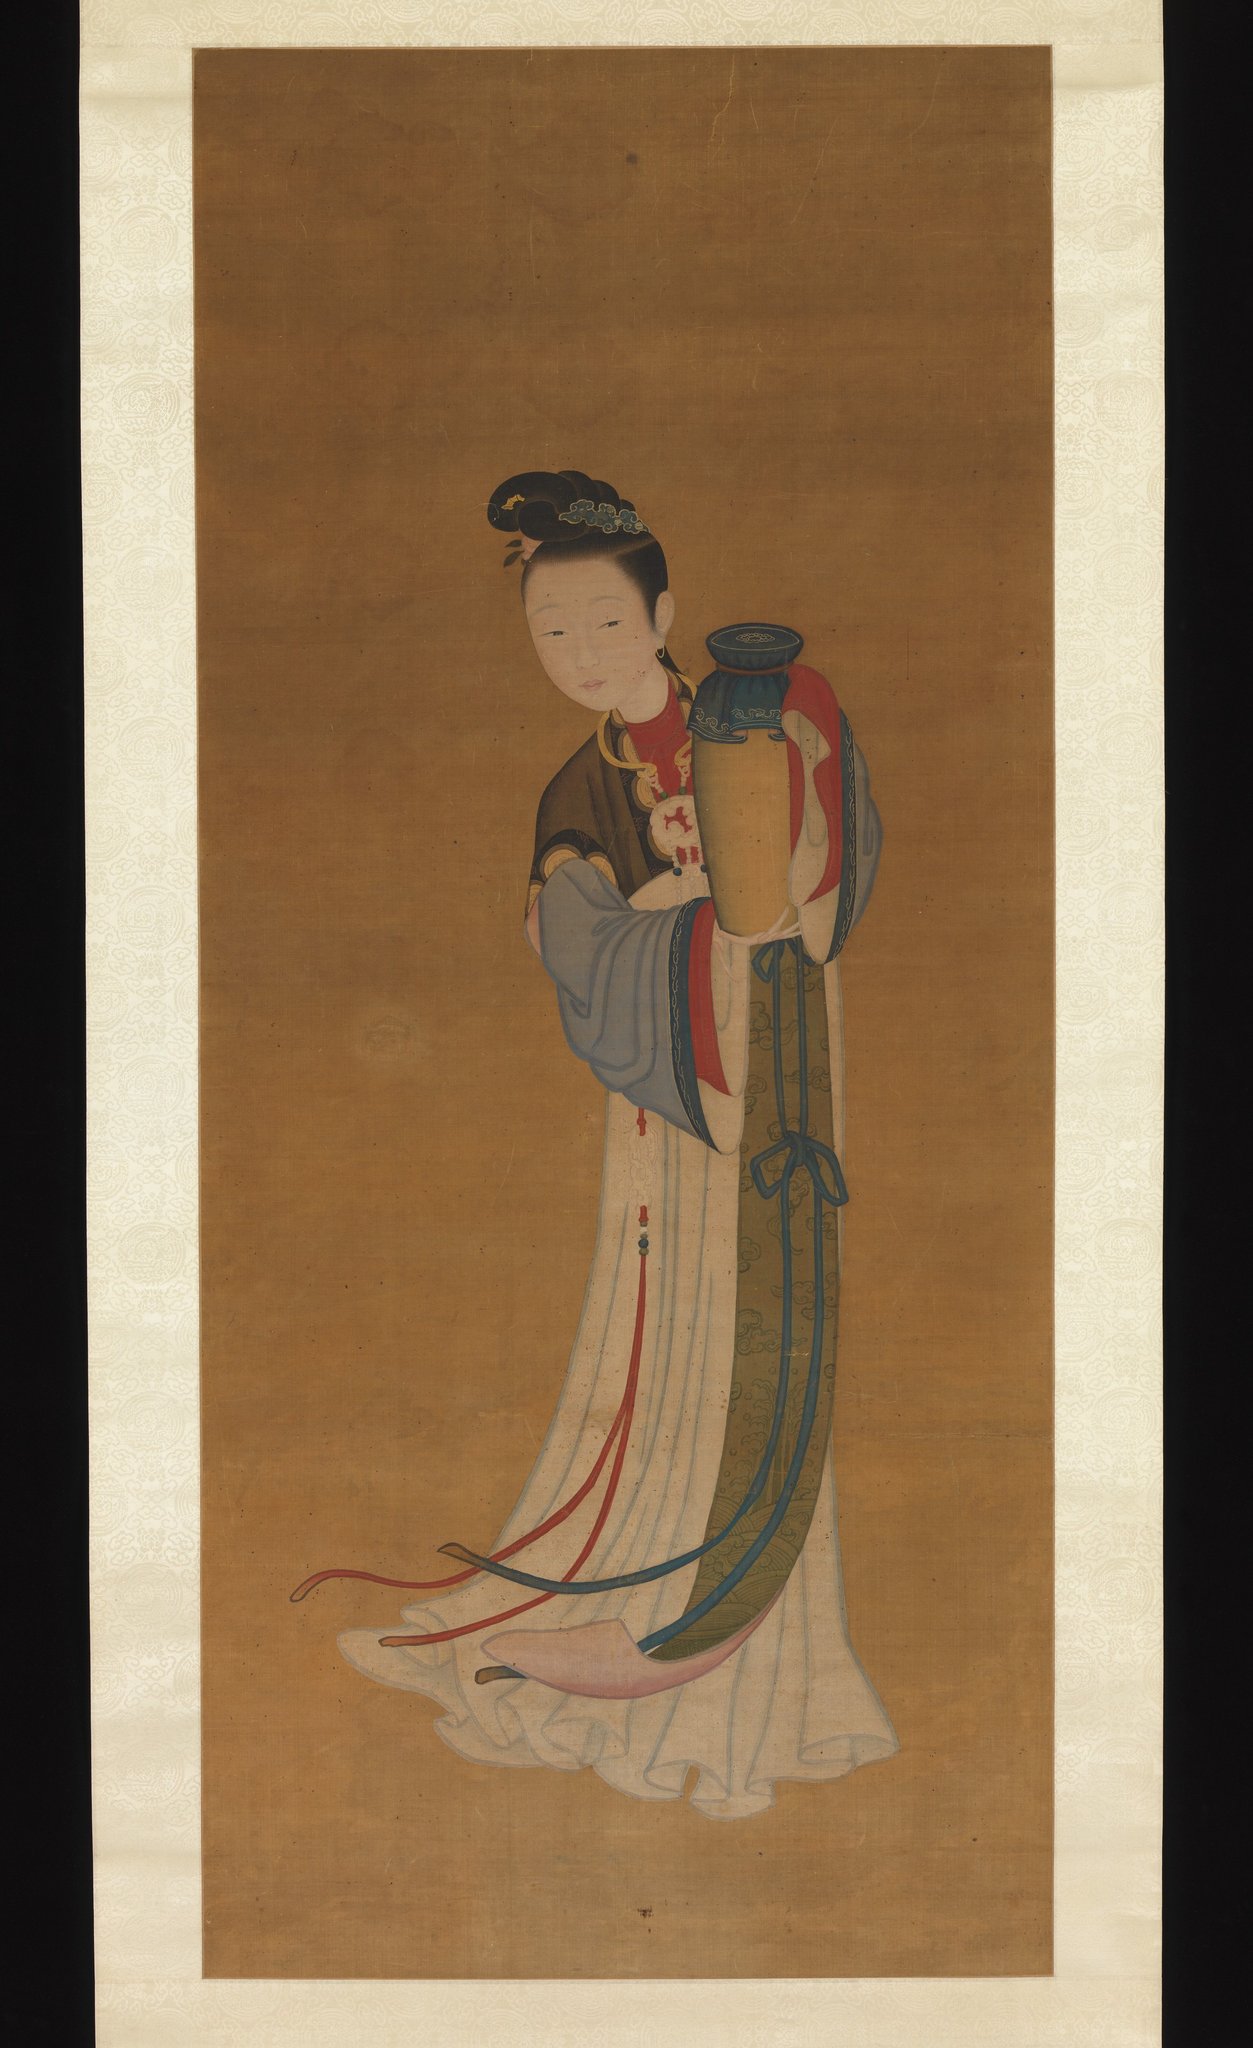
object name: hanging scroll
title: Girl Bringing Jar of Wine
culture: chinese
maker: unidentified artist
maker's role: artist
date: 1701-1800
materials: ink, silk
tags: girls